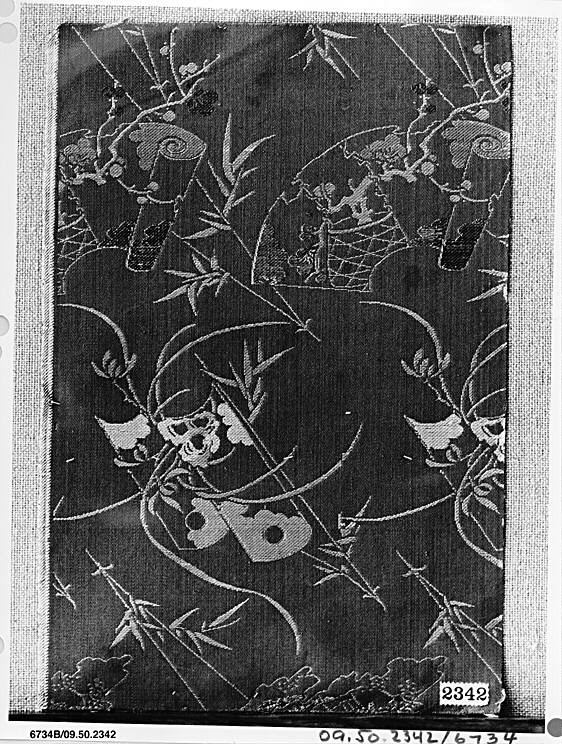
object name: piece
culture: japanese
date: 1801-1900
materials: silk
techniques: brocade